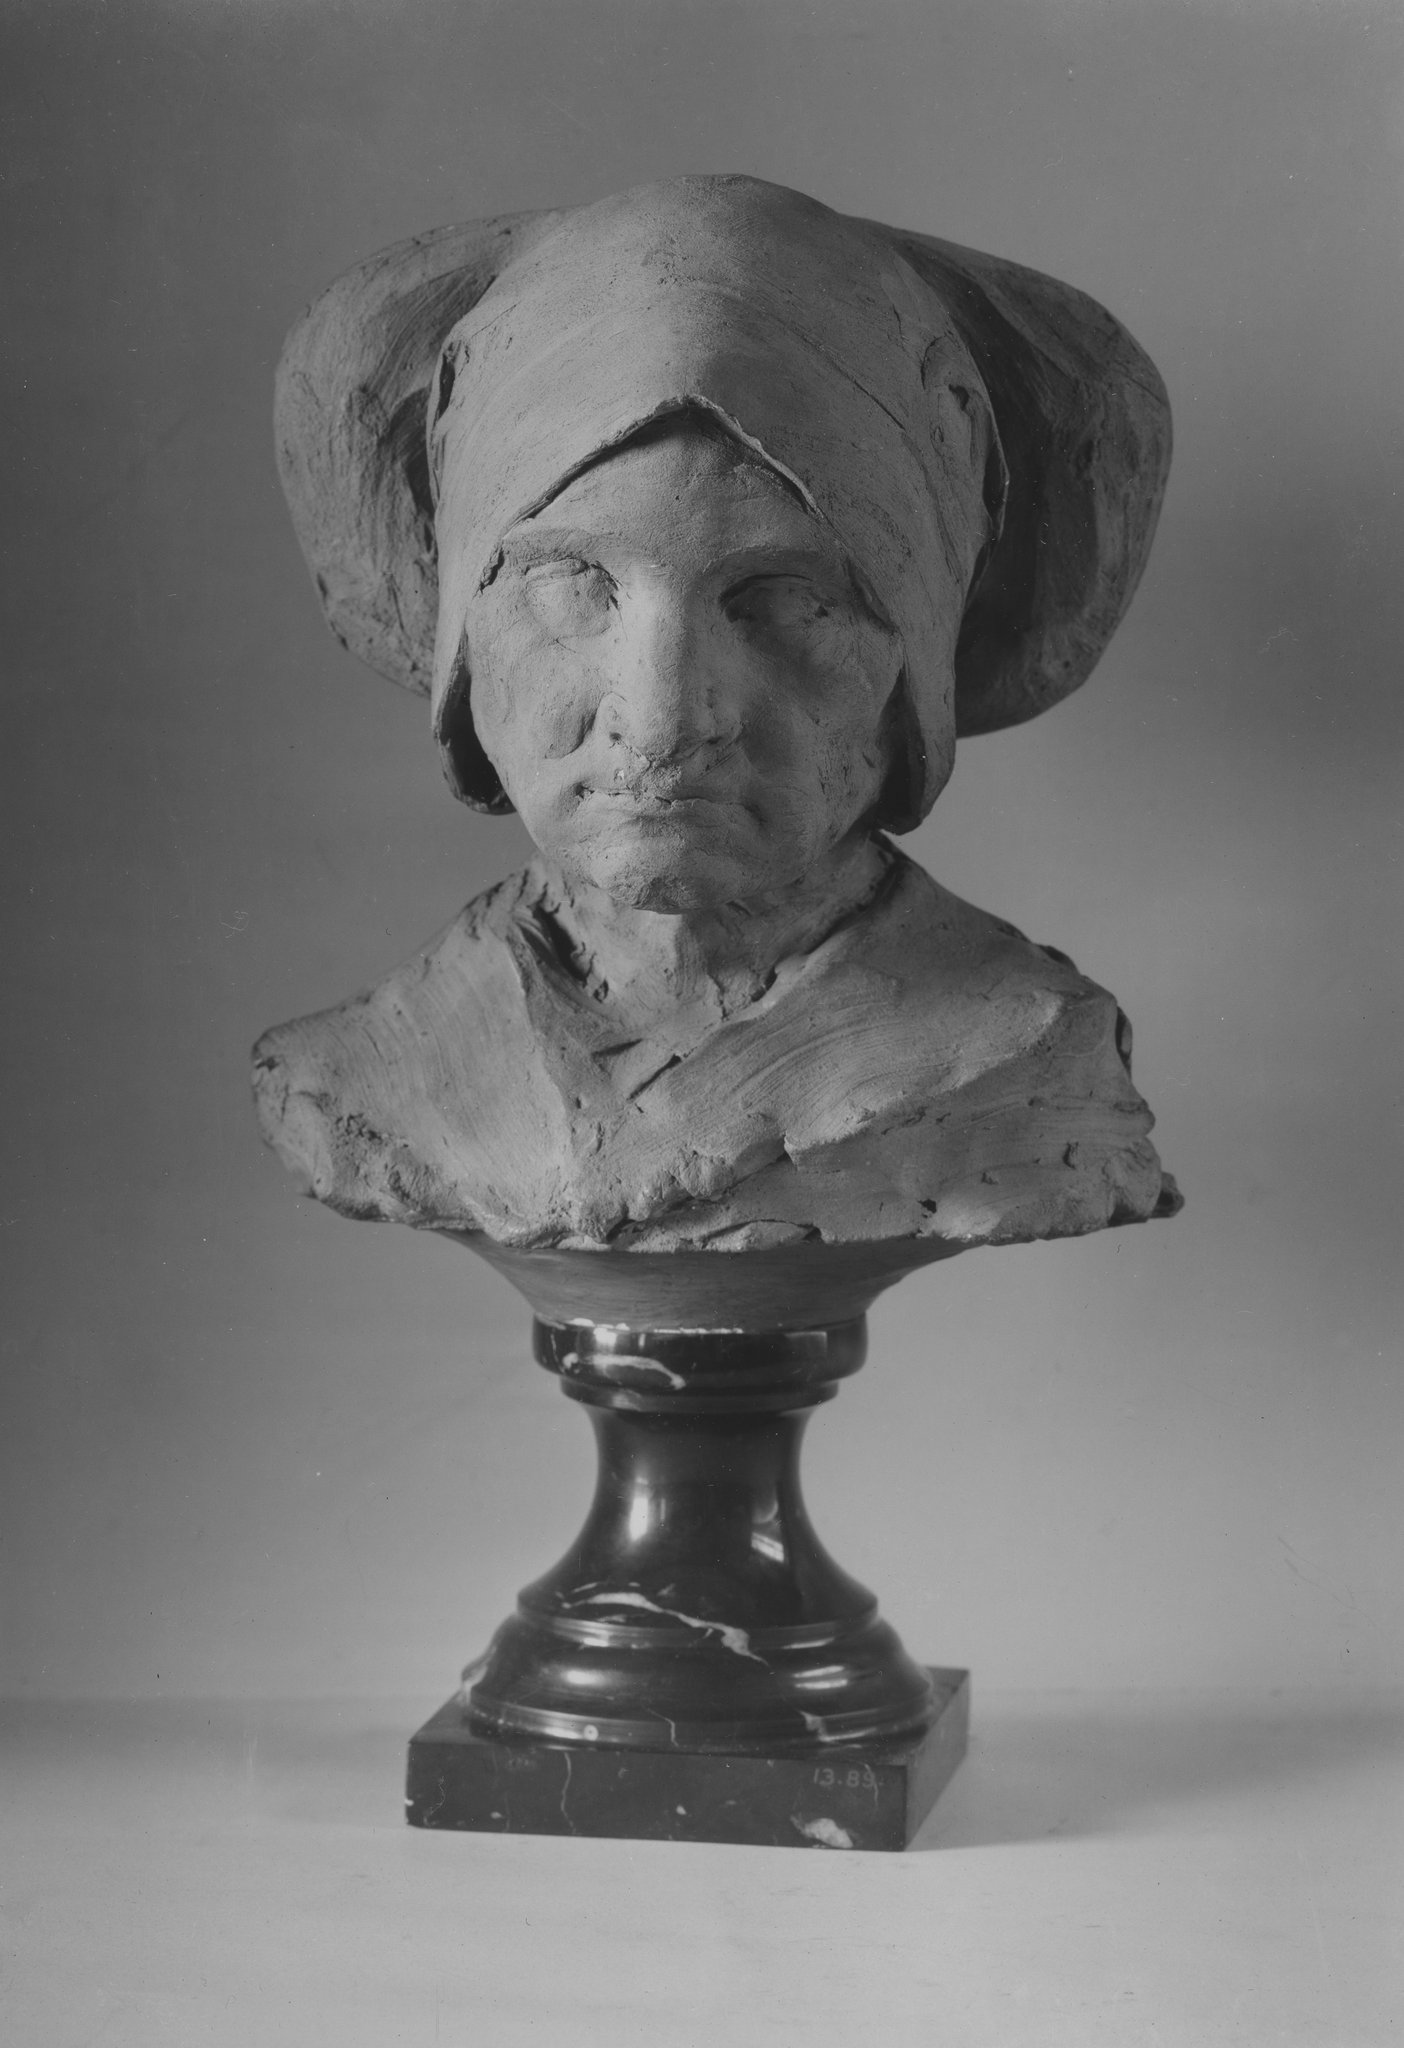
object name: bust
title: Breton Peasant Woman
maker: aimé-jules dalou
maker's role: artist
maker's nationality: french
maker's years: 1838-1902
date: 1880-1889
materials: marble, terracotta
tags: women